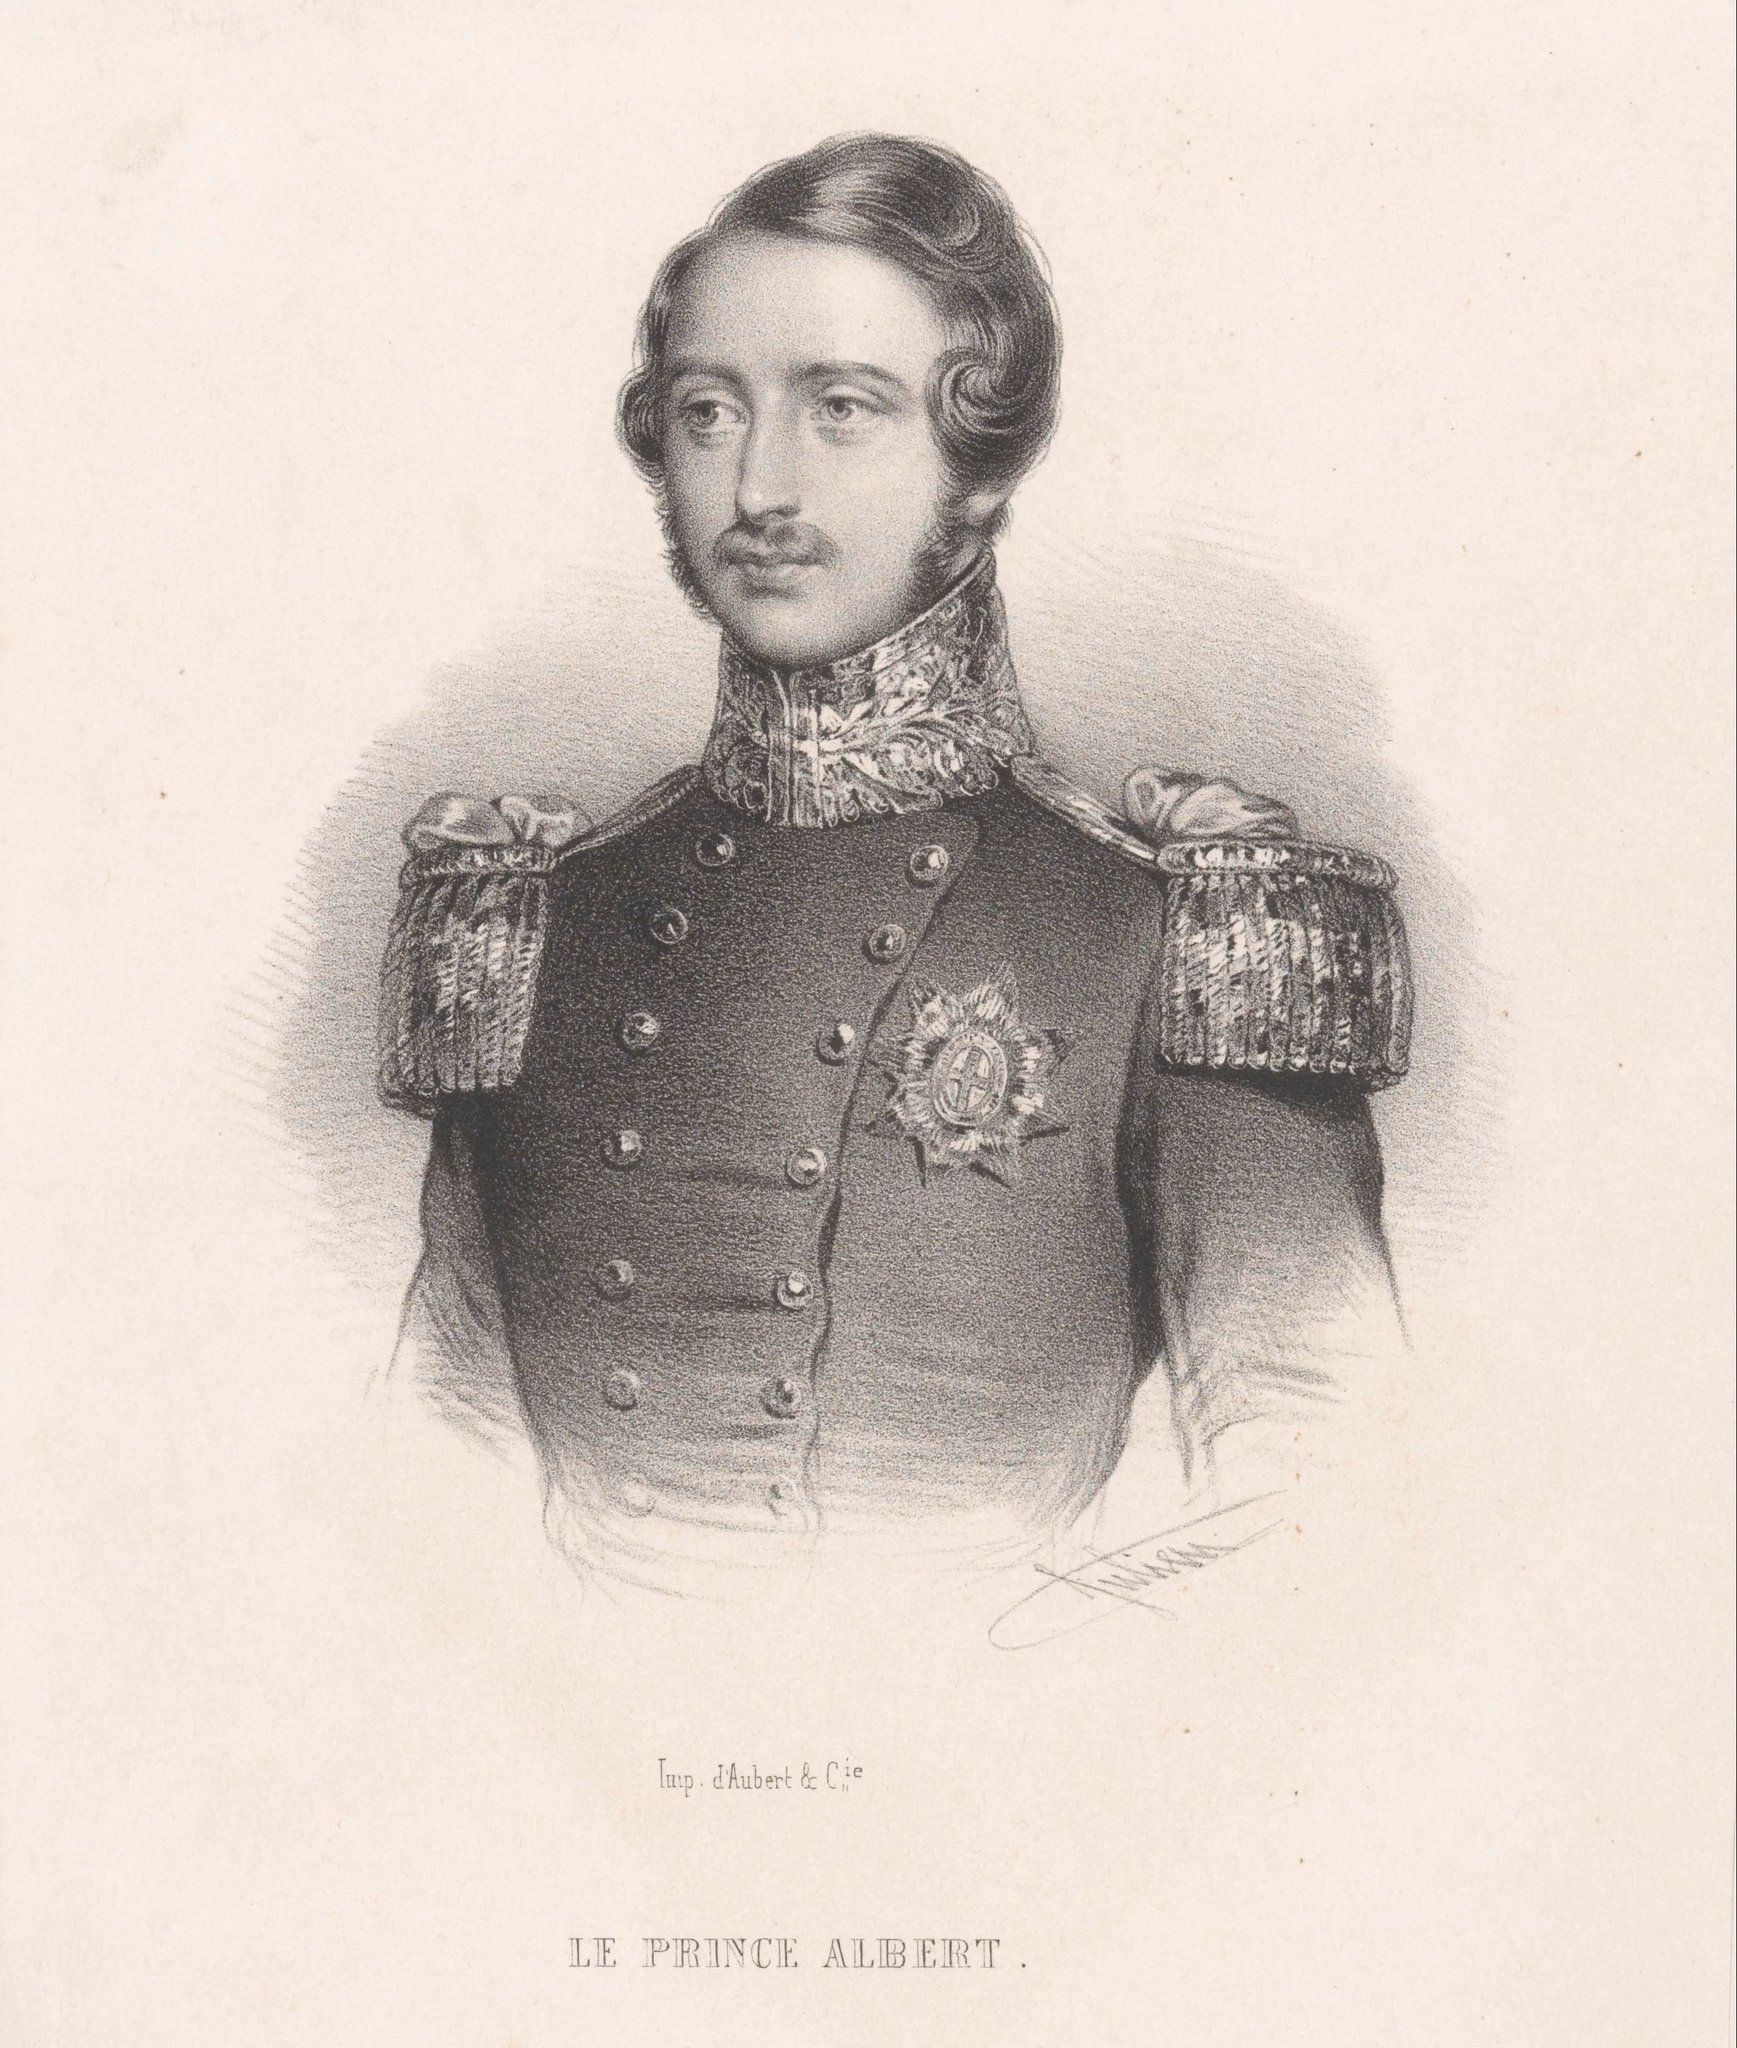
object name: print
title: Portret van Albert, prins van Saksen-Coburg en Gotha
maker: bernard romain julien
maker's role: print maker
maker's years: 1802-1871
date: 1840-1847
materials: paper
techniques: lithograph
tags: albert (prins van saksen-coburg en gotha)